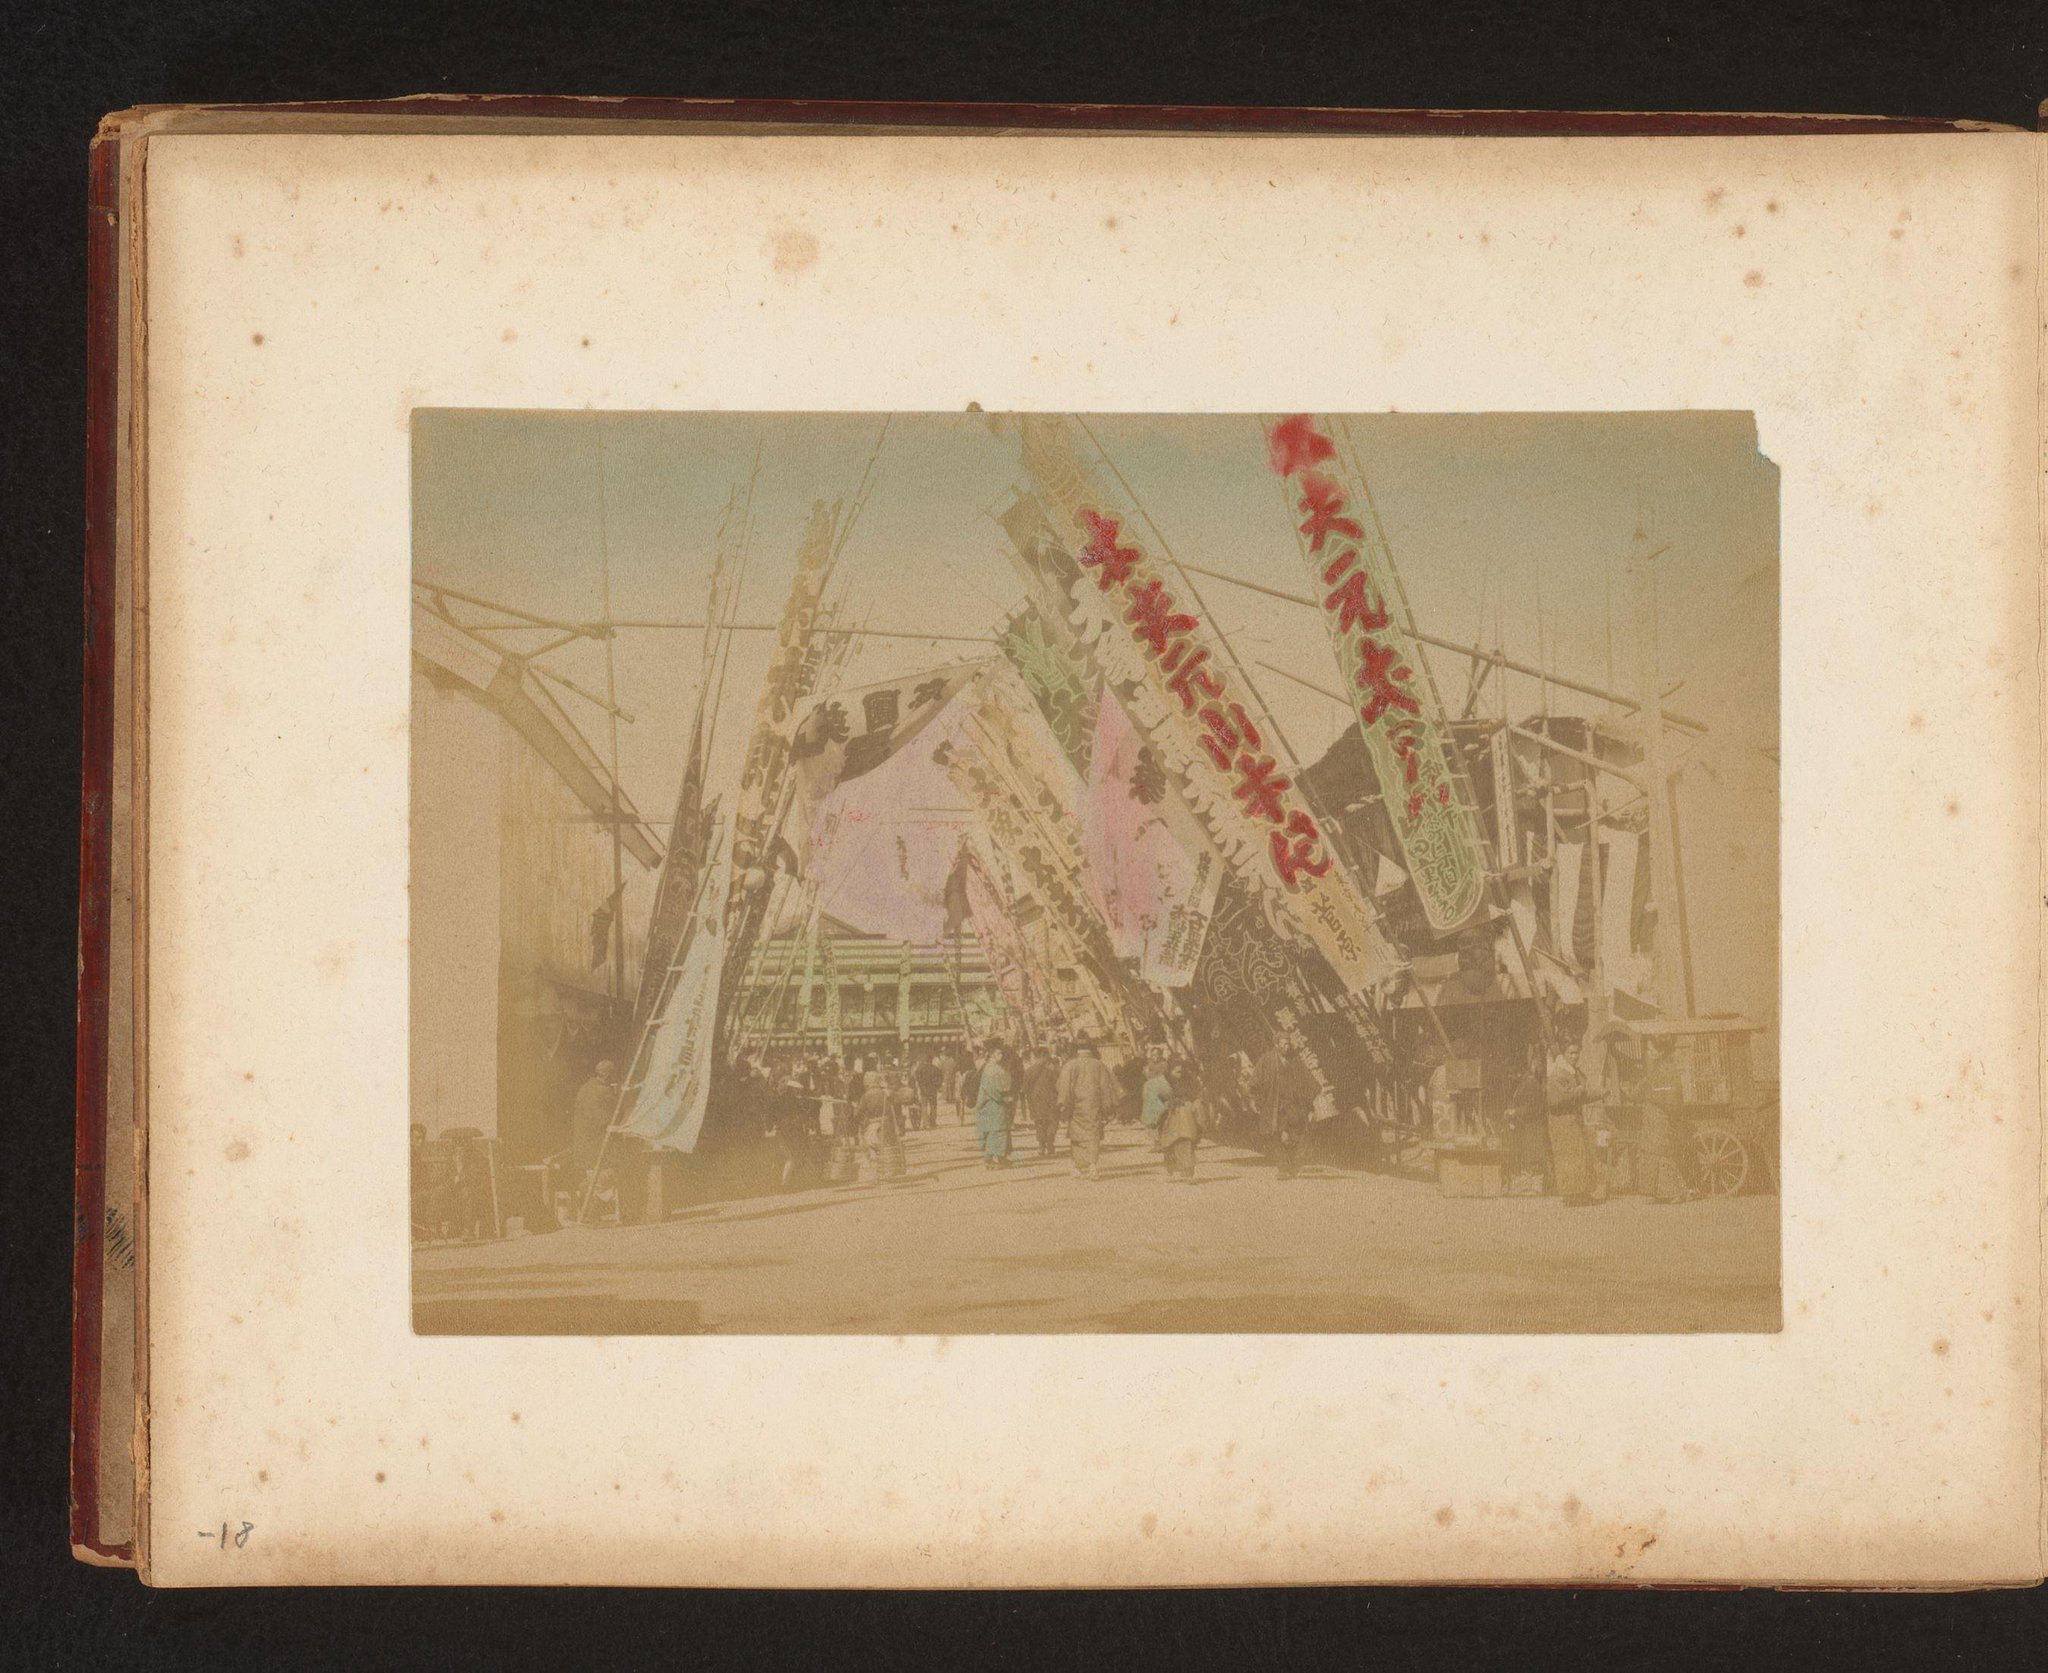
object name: album leaf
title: Festiviteiten in Japan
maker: Anonymous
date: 1851-1900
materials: paper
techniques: albumen print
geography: japan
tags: public festivities, japan